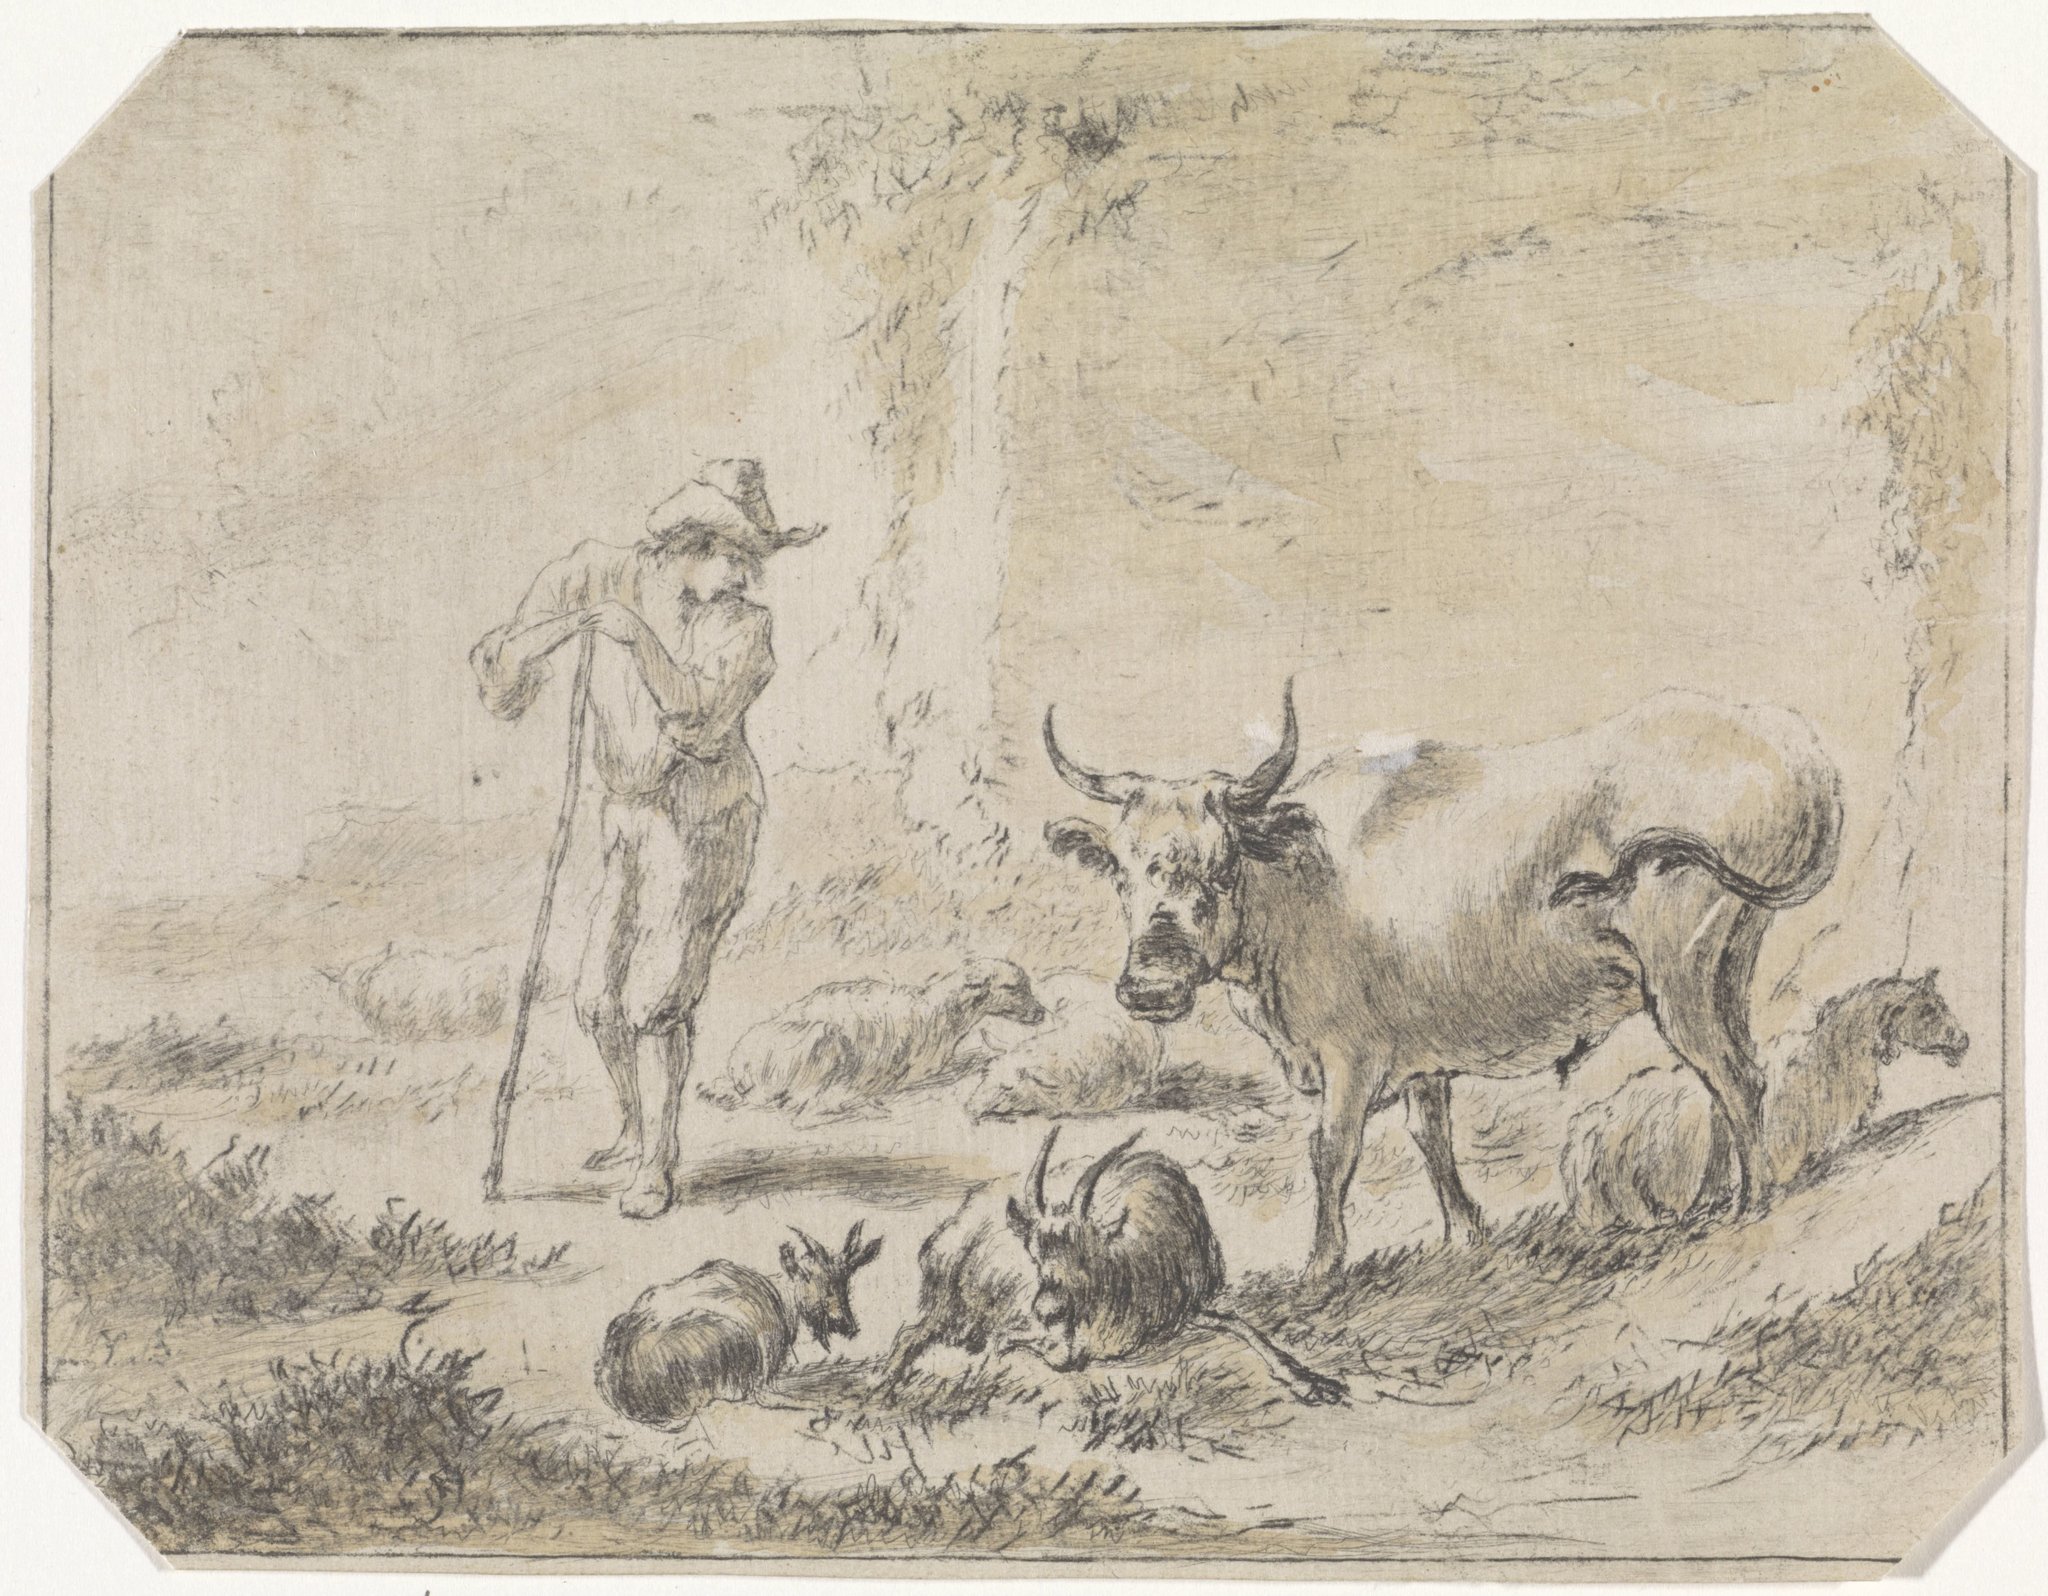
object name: print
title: Herder leunend op zijn staf tussen zijn vee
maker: hendrik spilman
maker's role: draughtsman, painter, print maker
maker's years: 1721-1784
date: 1742-1784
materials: paper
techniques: brush, etching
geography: haarlem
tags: leaning forward, herding, herdsman, herdswoman, shepherd, shepherdess, cowherd, etc., cattle, walking-stick, staff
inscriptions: collector's mark: Lugt 2228